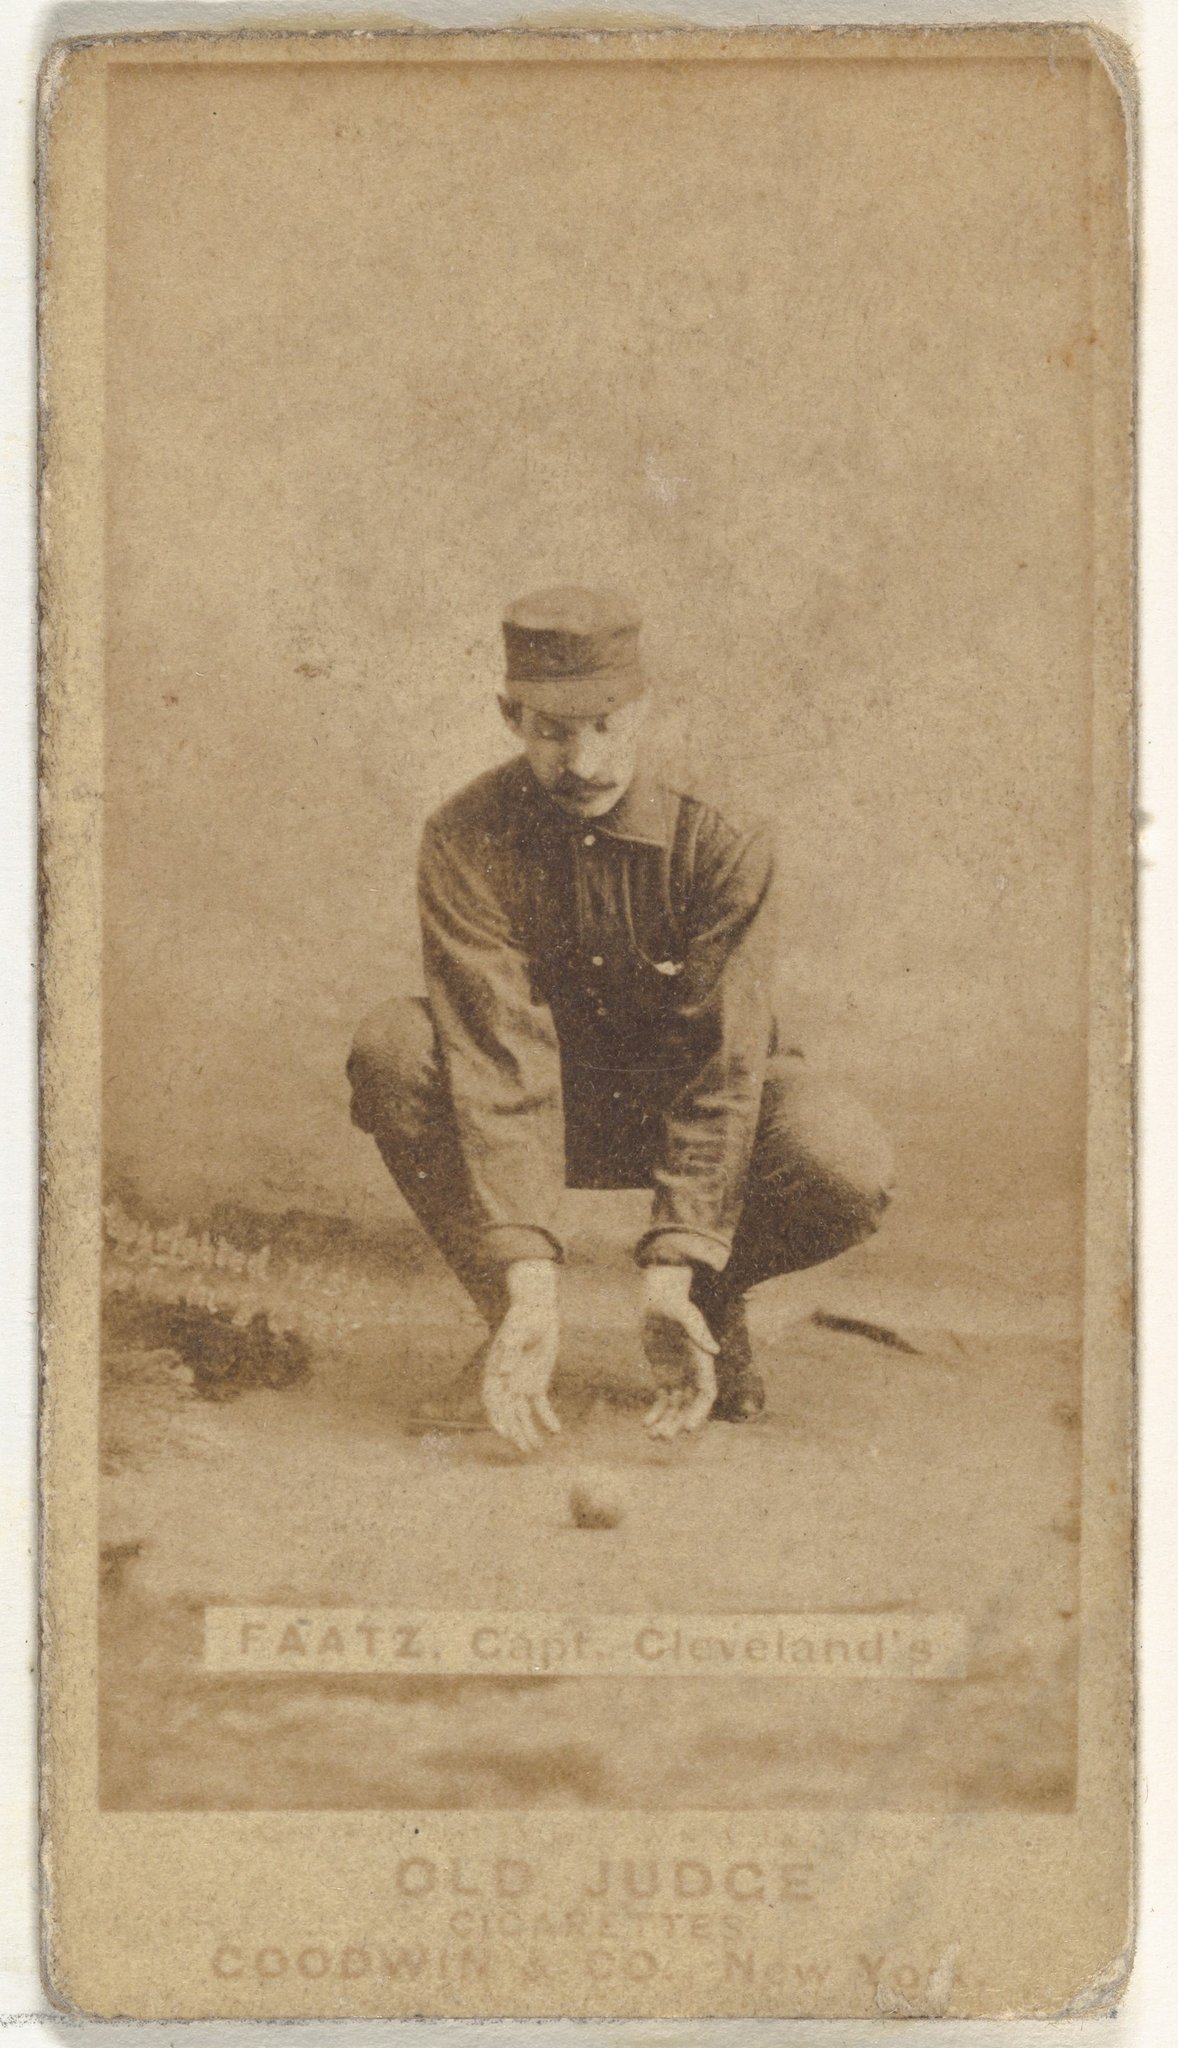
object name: baseball card, photograph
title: Jayson S. "Jay" Faatz, Captain, Cleveland, from the Old Judge series (N172) for Old Judge Cigarettes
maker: goodwin & company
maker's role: publisher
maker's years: 1850-1950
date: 1888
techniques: albumen silver print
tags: men,portraits,baseball,athletes